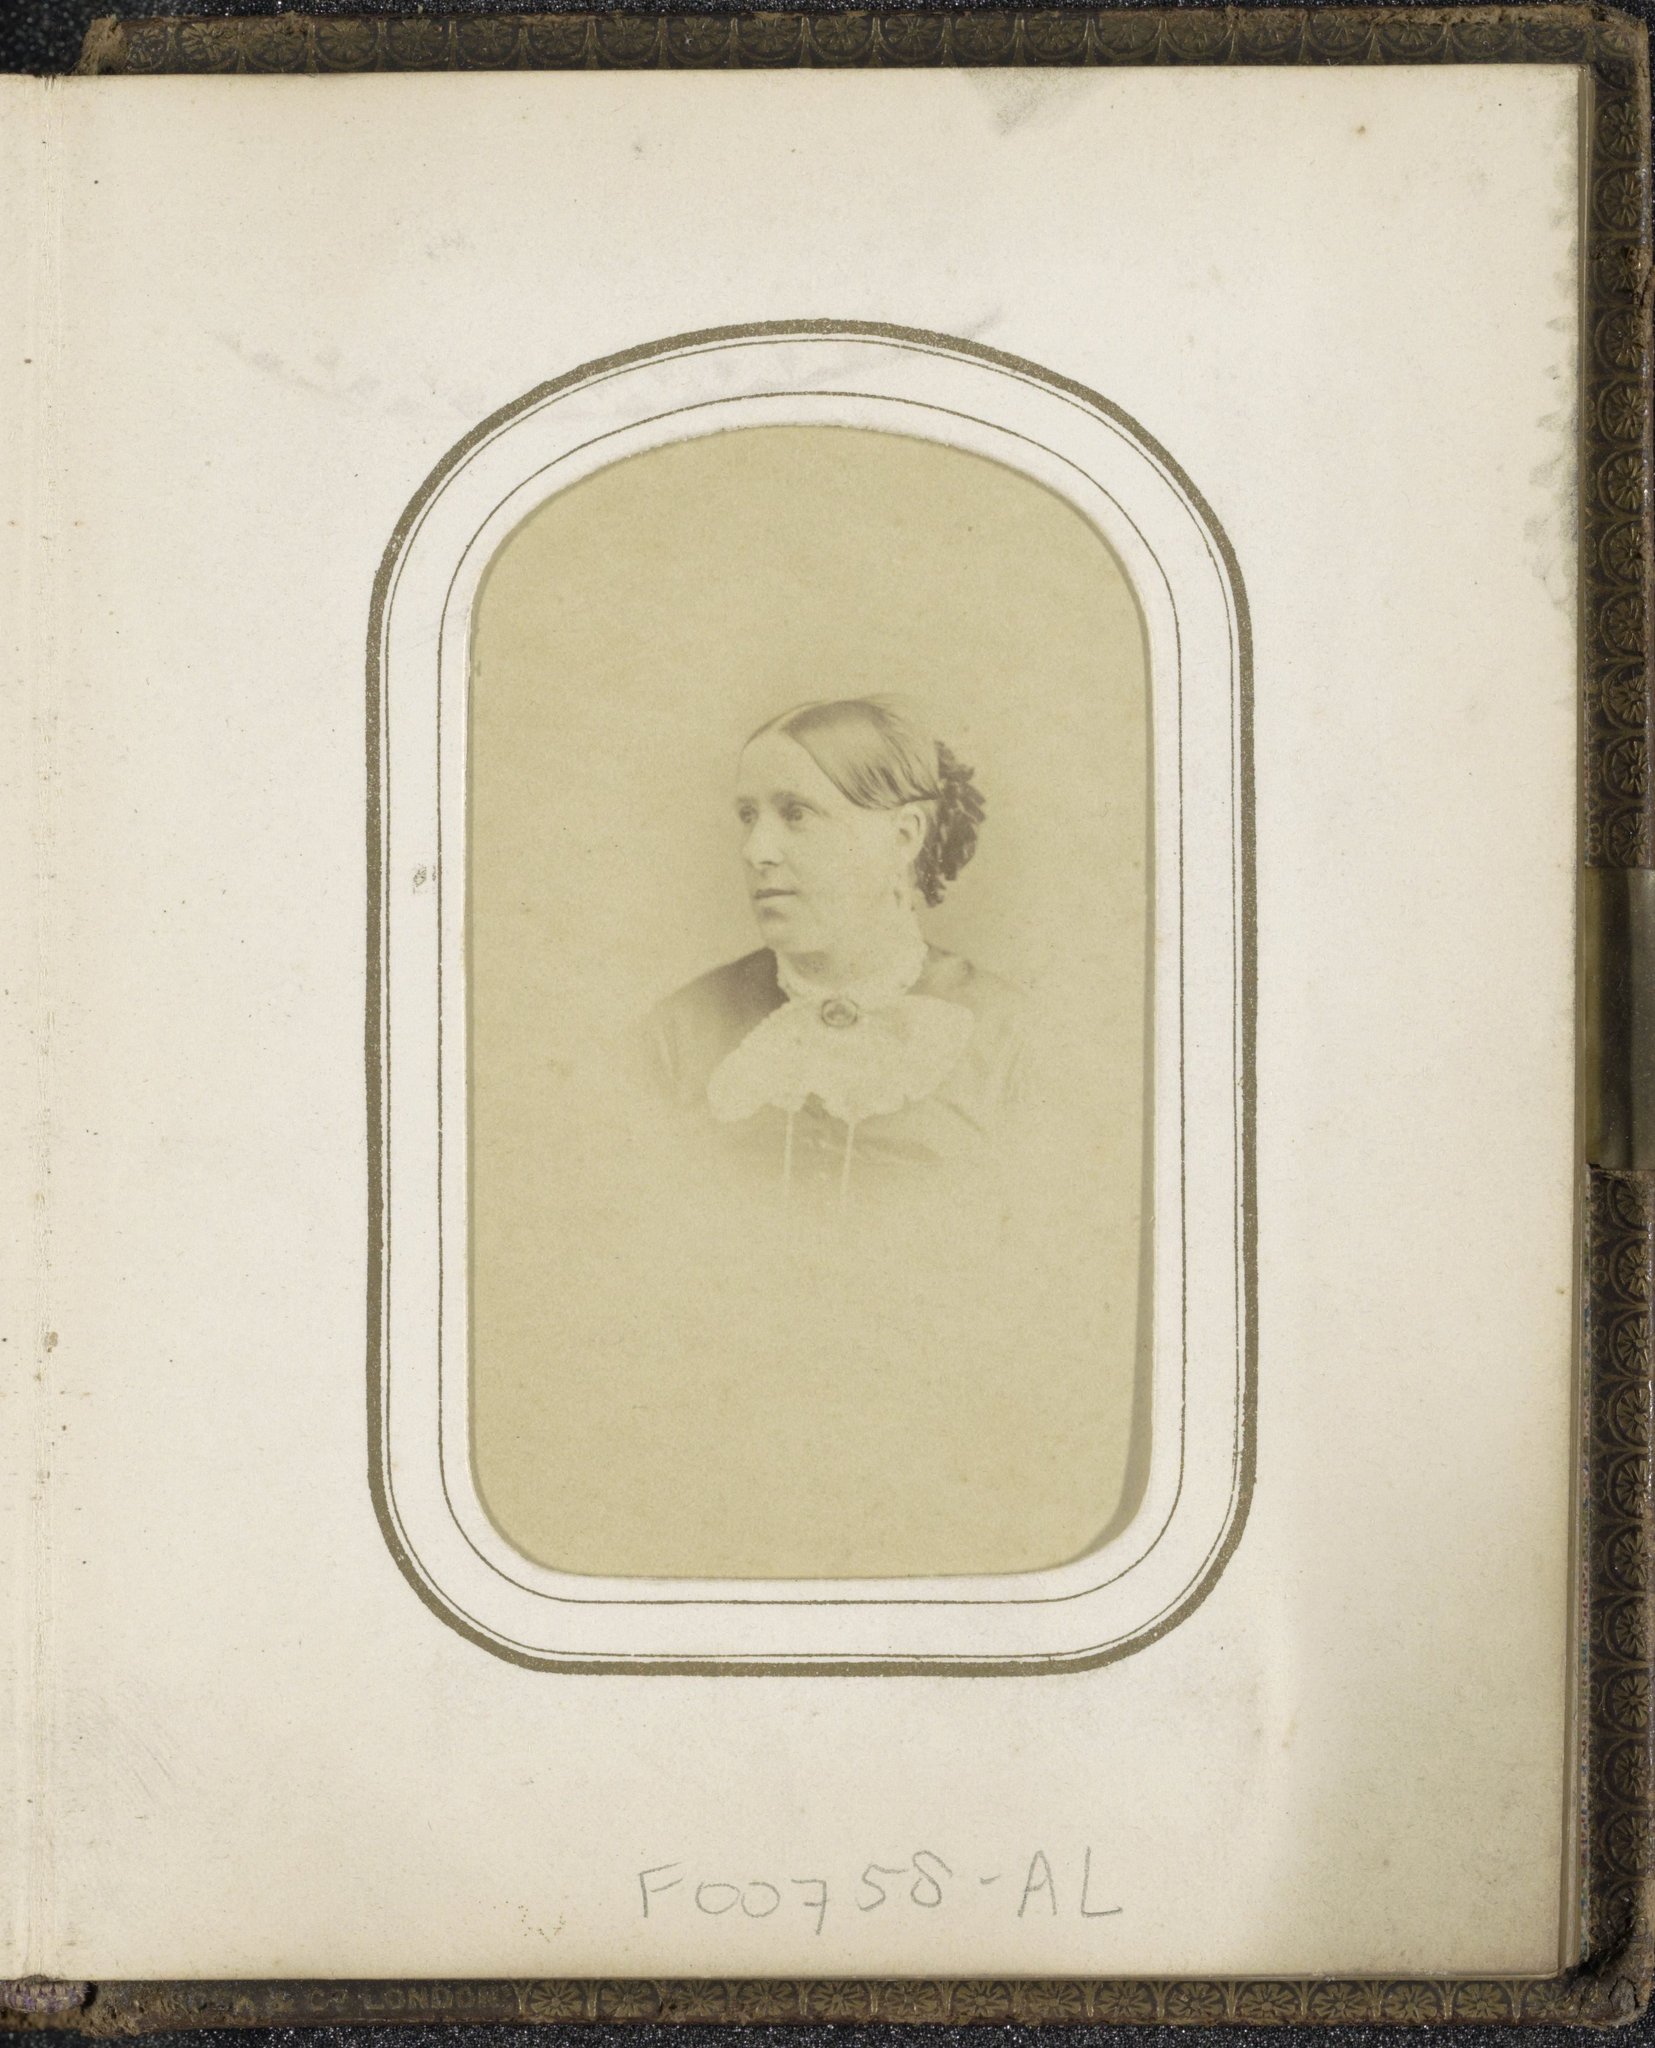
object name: photograph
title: Portret van een vrouw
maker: james s. bayfield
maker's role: fotograaf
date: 1870-1880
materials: cardboard, paper, photographic support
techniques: albumen print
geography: hastings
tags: historical persons, styles of hairdress - aa - ~ women, neck-gear: collar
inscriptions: address: ‘Hastings, 25 White Rock’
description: Onderdeel van Engels fotoalbum van E.A. Kettle met 42 cartes-de-visite.